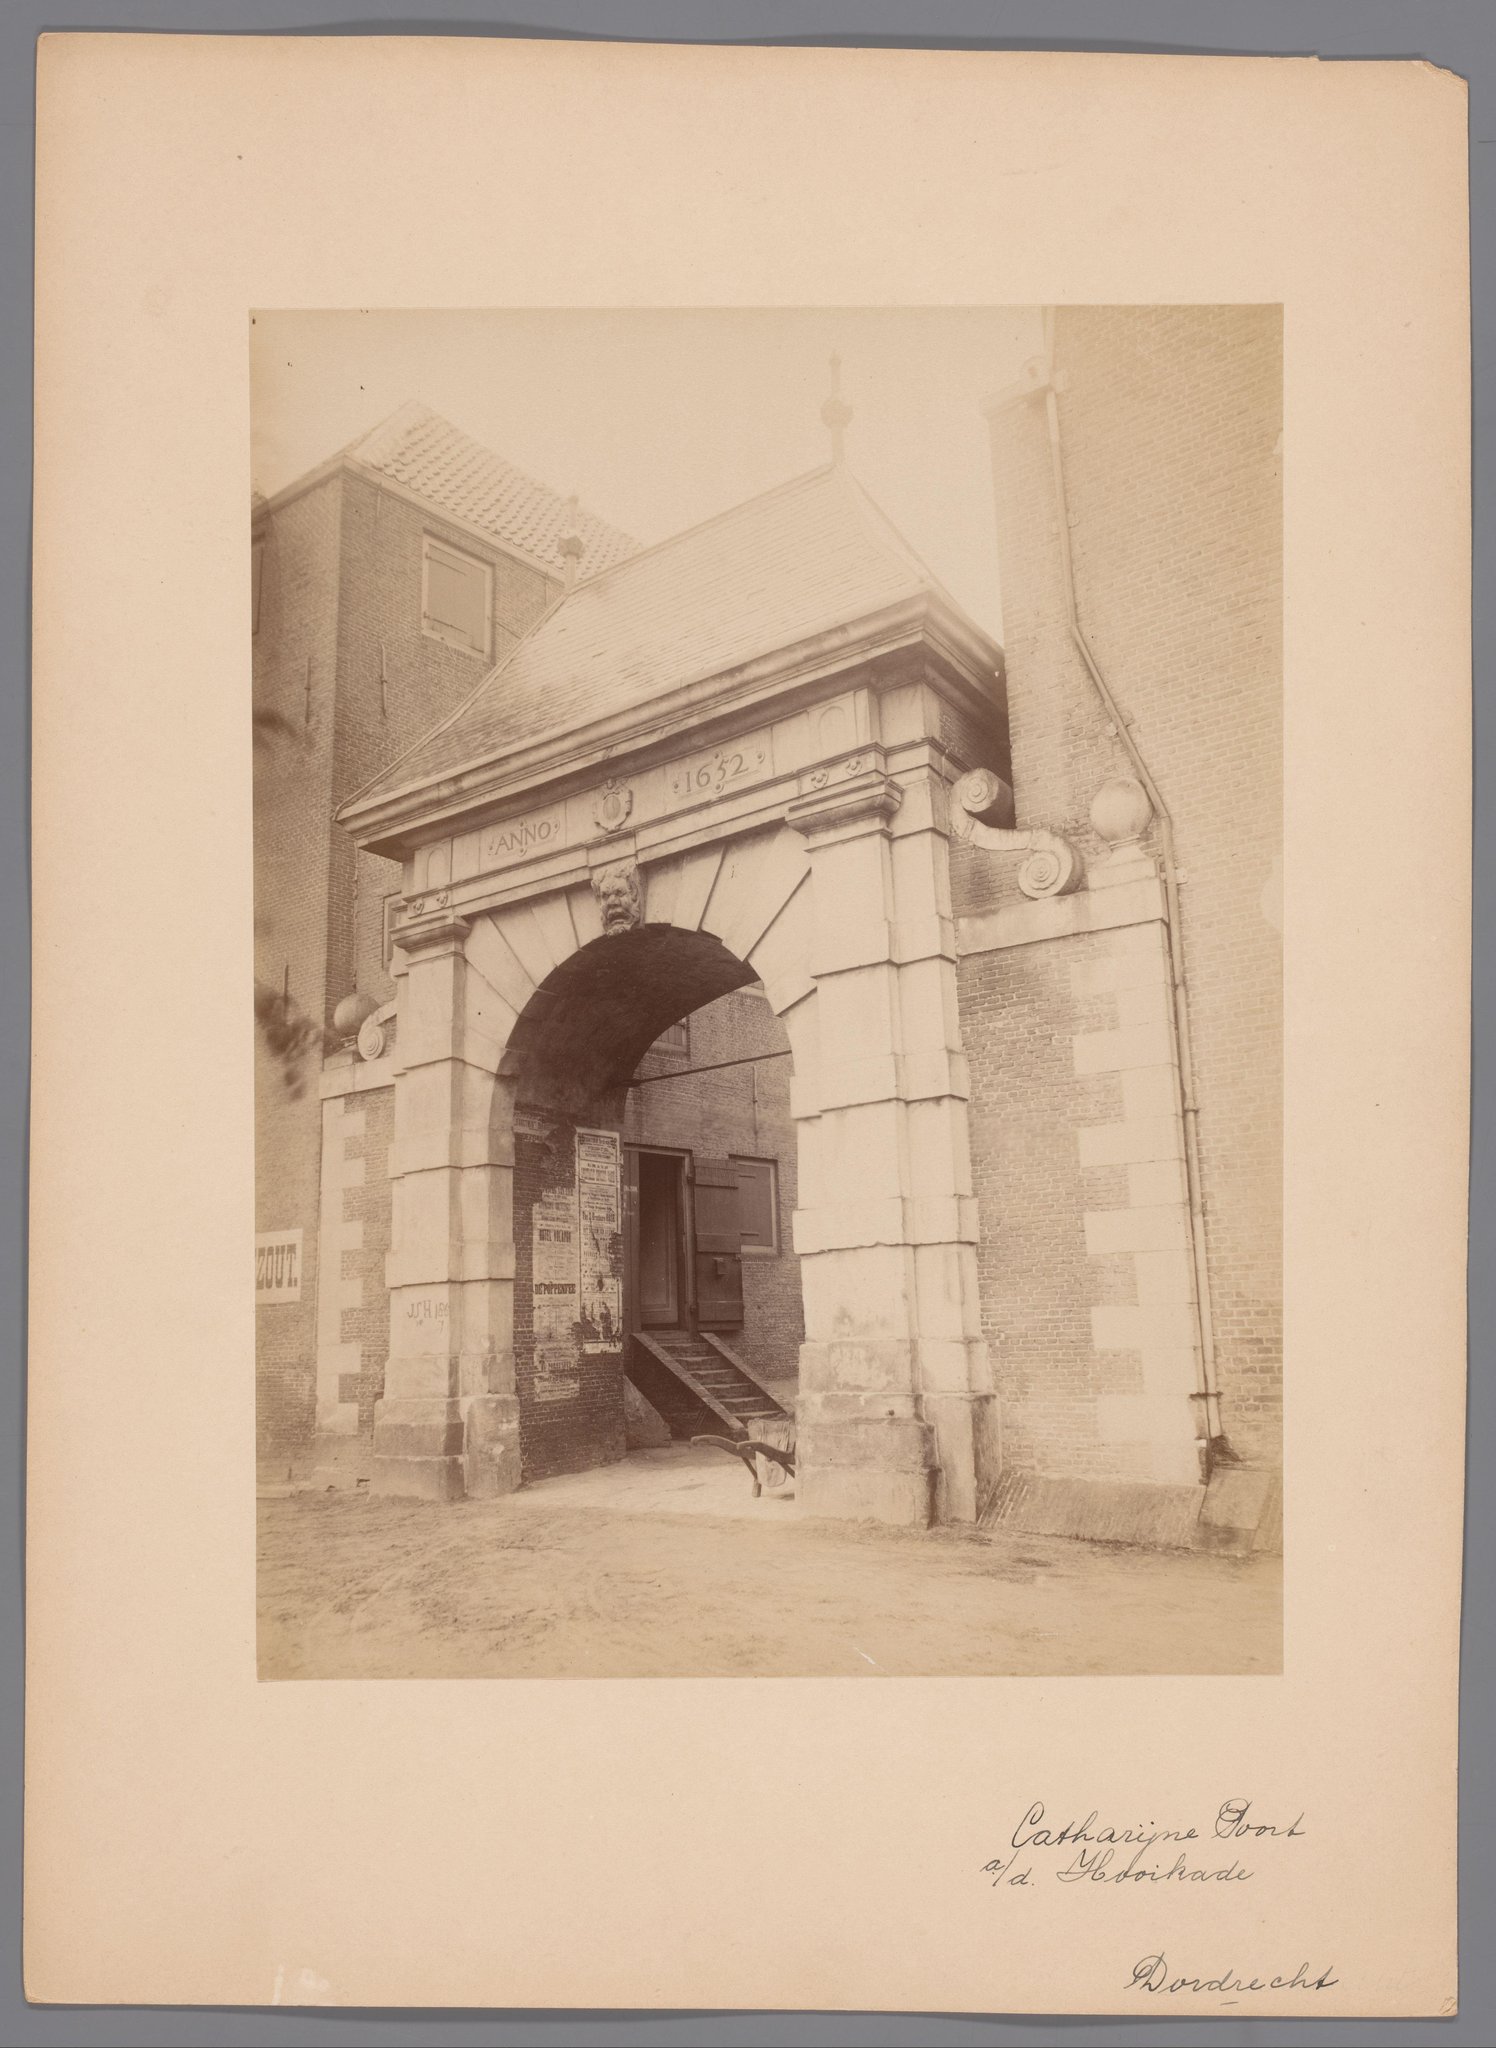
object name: photograph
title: Catharijnepoort aan de Hooikade te Dordrecht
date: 1880-1910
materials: cardboard, photographic support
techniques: albumen print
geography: hooikade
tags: gate, entrance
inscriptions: annotation: ‘Catharijne Poort a/d Hooikade/ Dordrecht’, annotation: ‘Dordrecht/ Catharijnepoort a/d Hooikade’